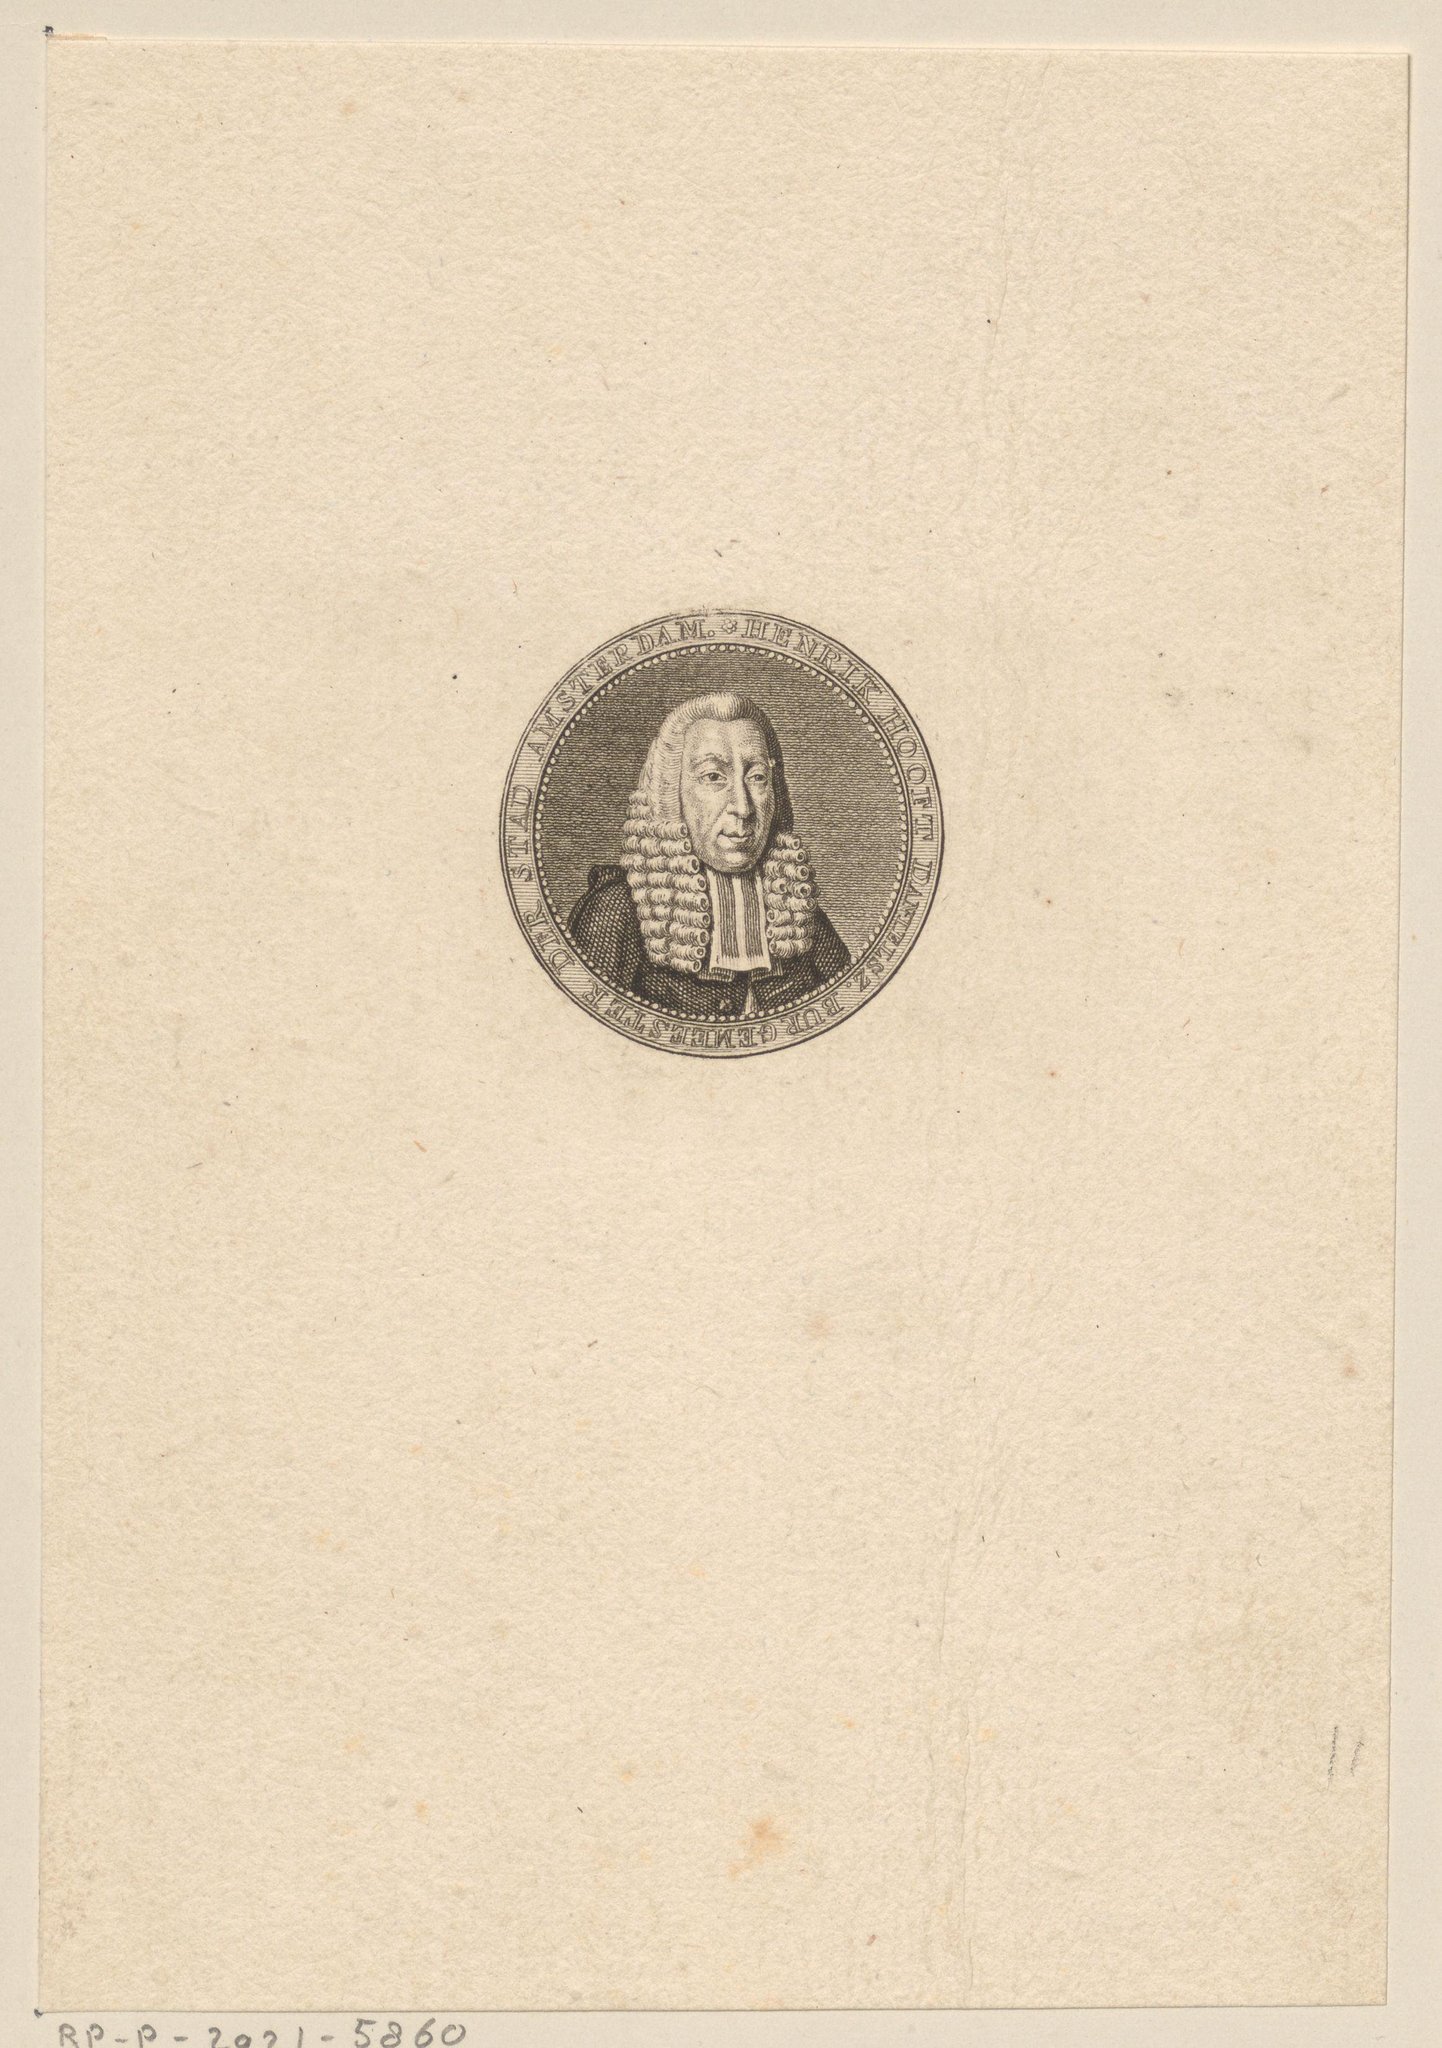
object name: print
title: Portret van Hendrik Danielsz. Hooft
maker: Anonymous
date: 1769-1799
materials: paper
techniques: etching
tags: amsterdam, hendrik danielsz. hooft, mayor, burgomaster, historical persons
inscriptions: collector's mark: Lugt 2228